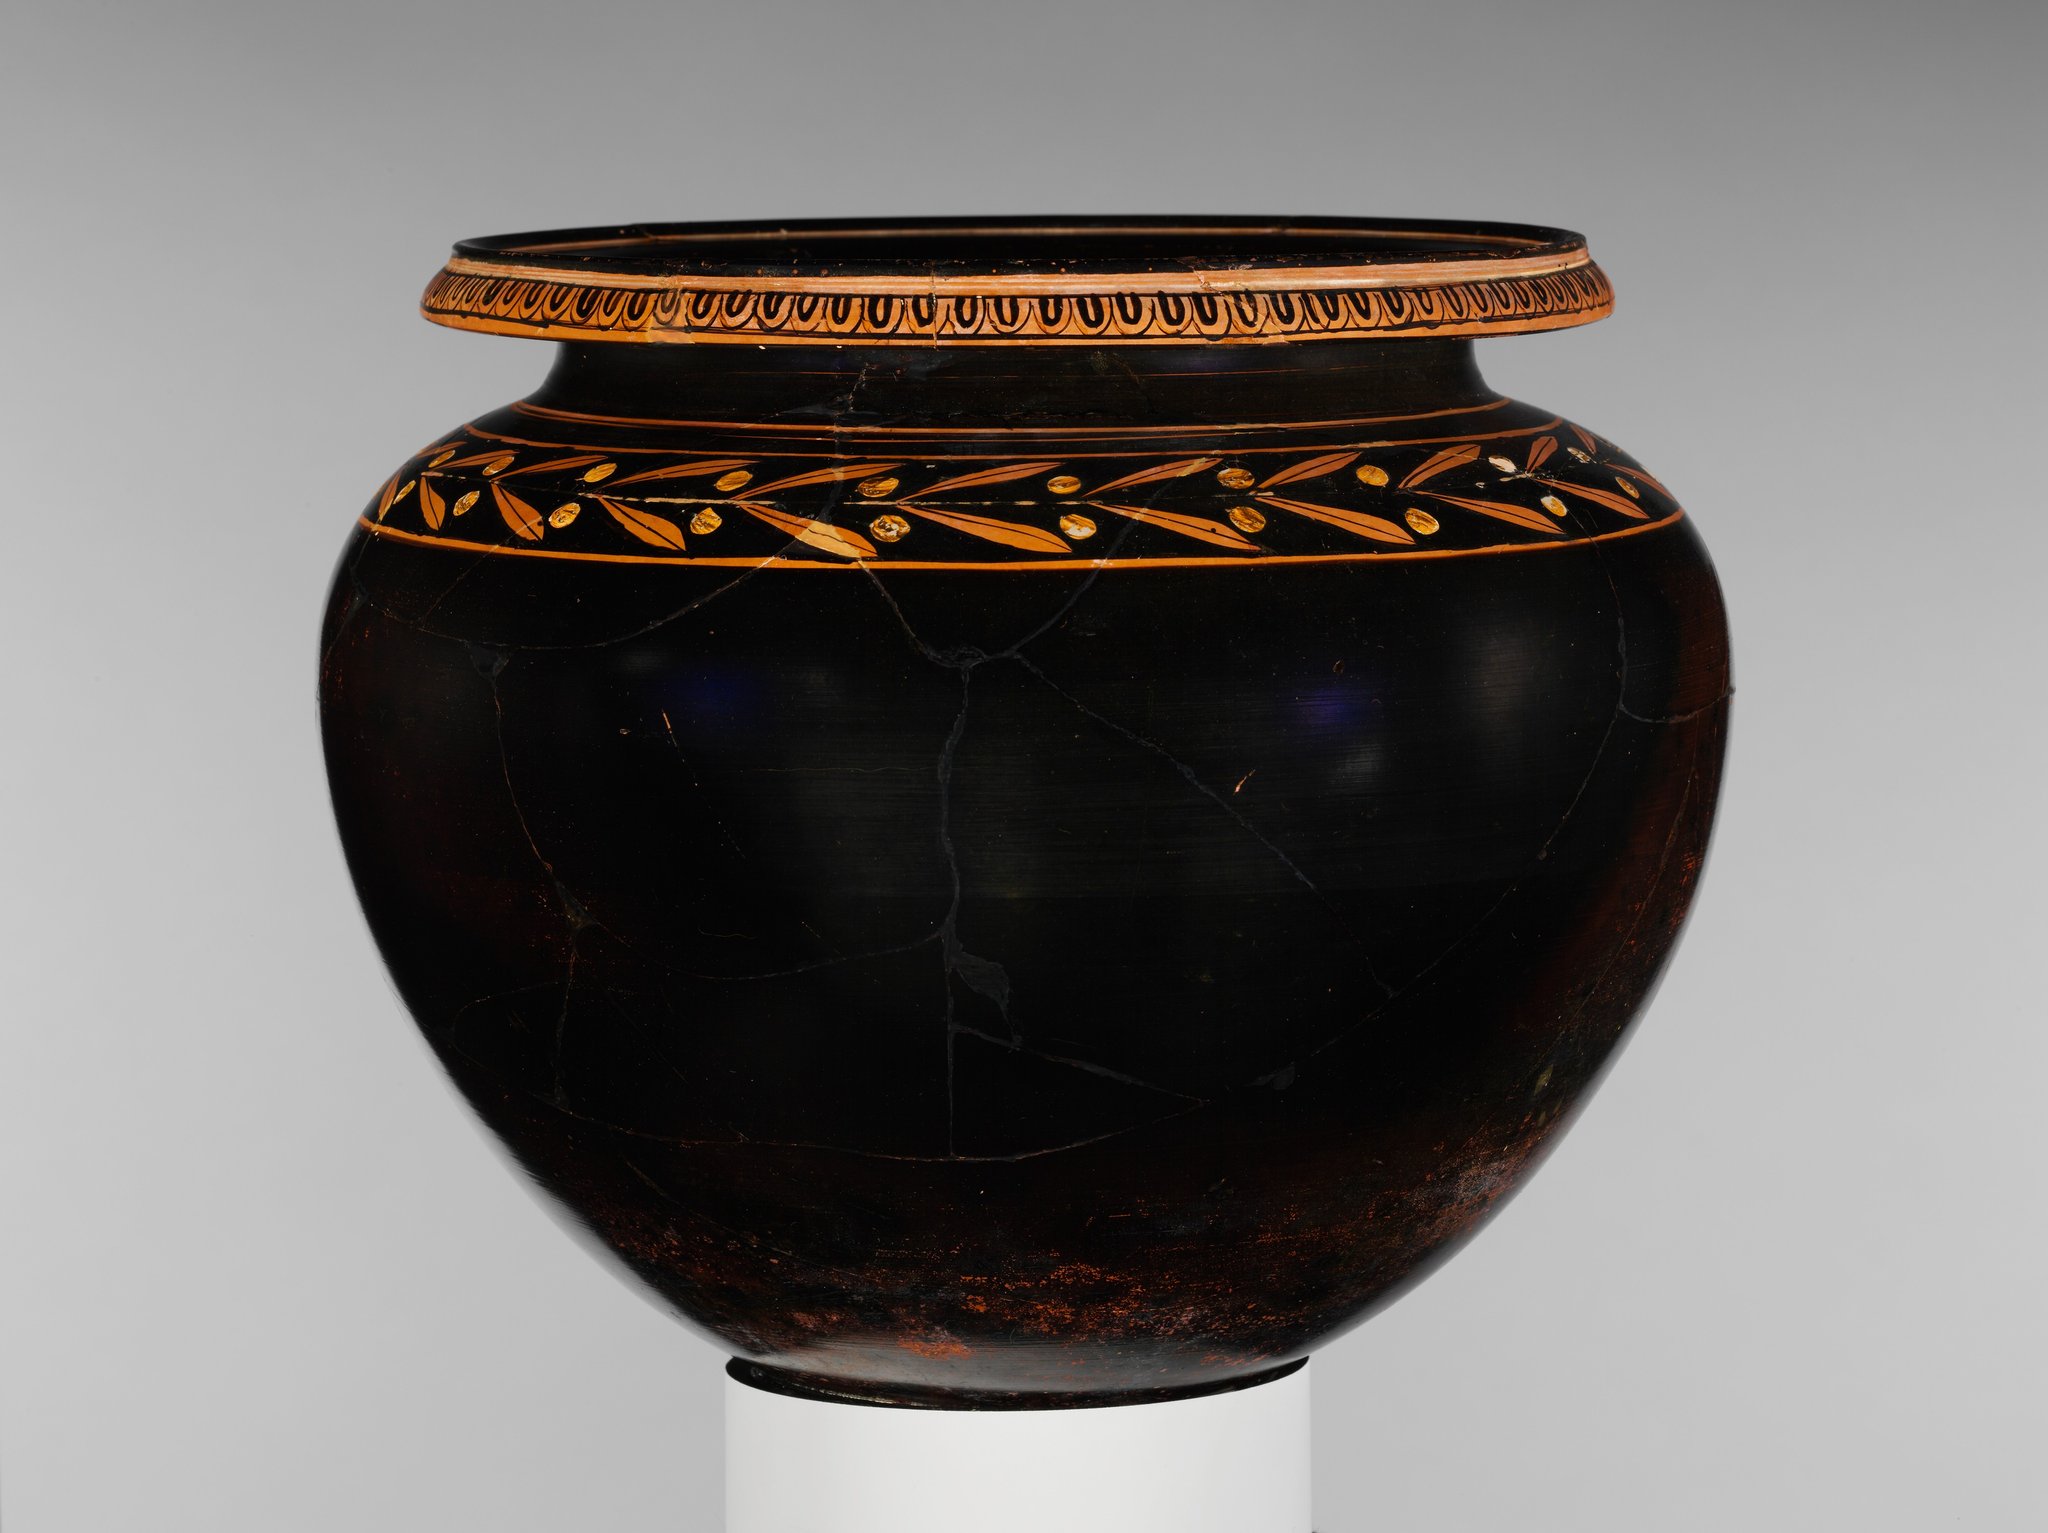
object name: lebes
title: Terracotta lebes (deep bowl)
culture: greek, attic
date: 450-425 BCE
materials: terracotta